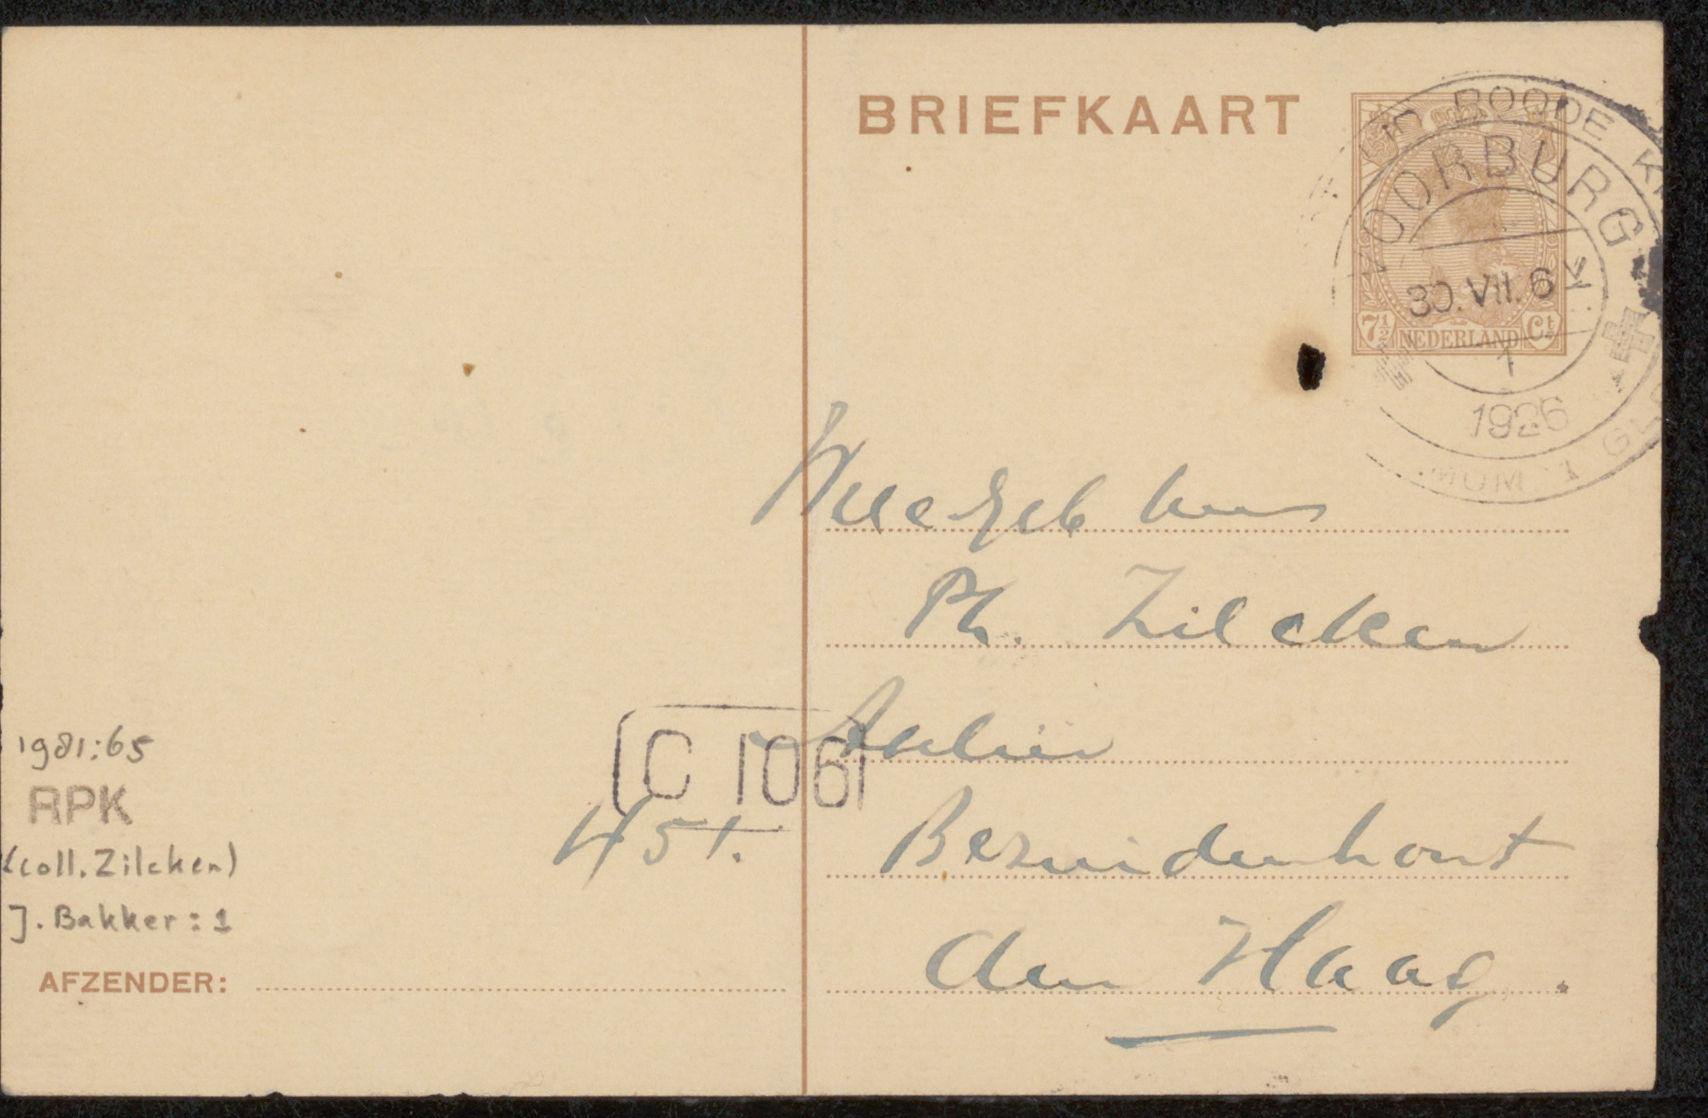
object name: postcard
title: Briefkaart aan Philip Zilcken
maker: jan bakker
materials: cardboard, ink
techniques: pen, writing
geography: voorburg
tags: painter, draughtsman, philip zilcken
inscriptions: collector's mark: ‘RPK’